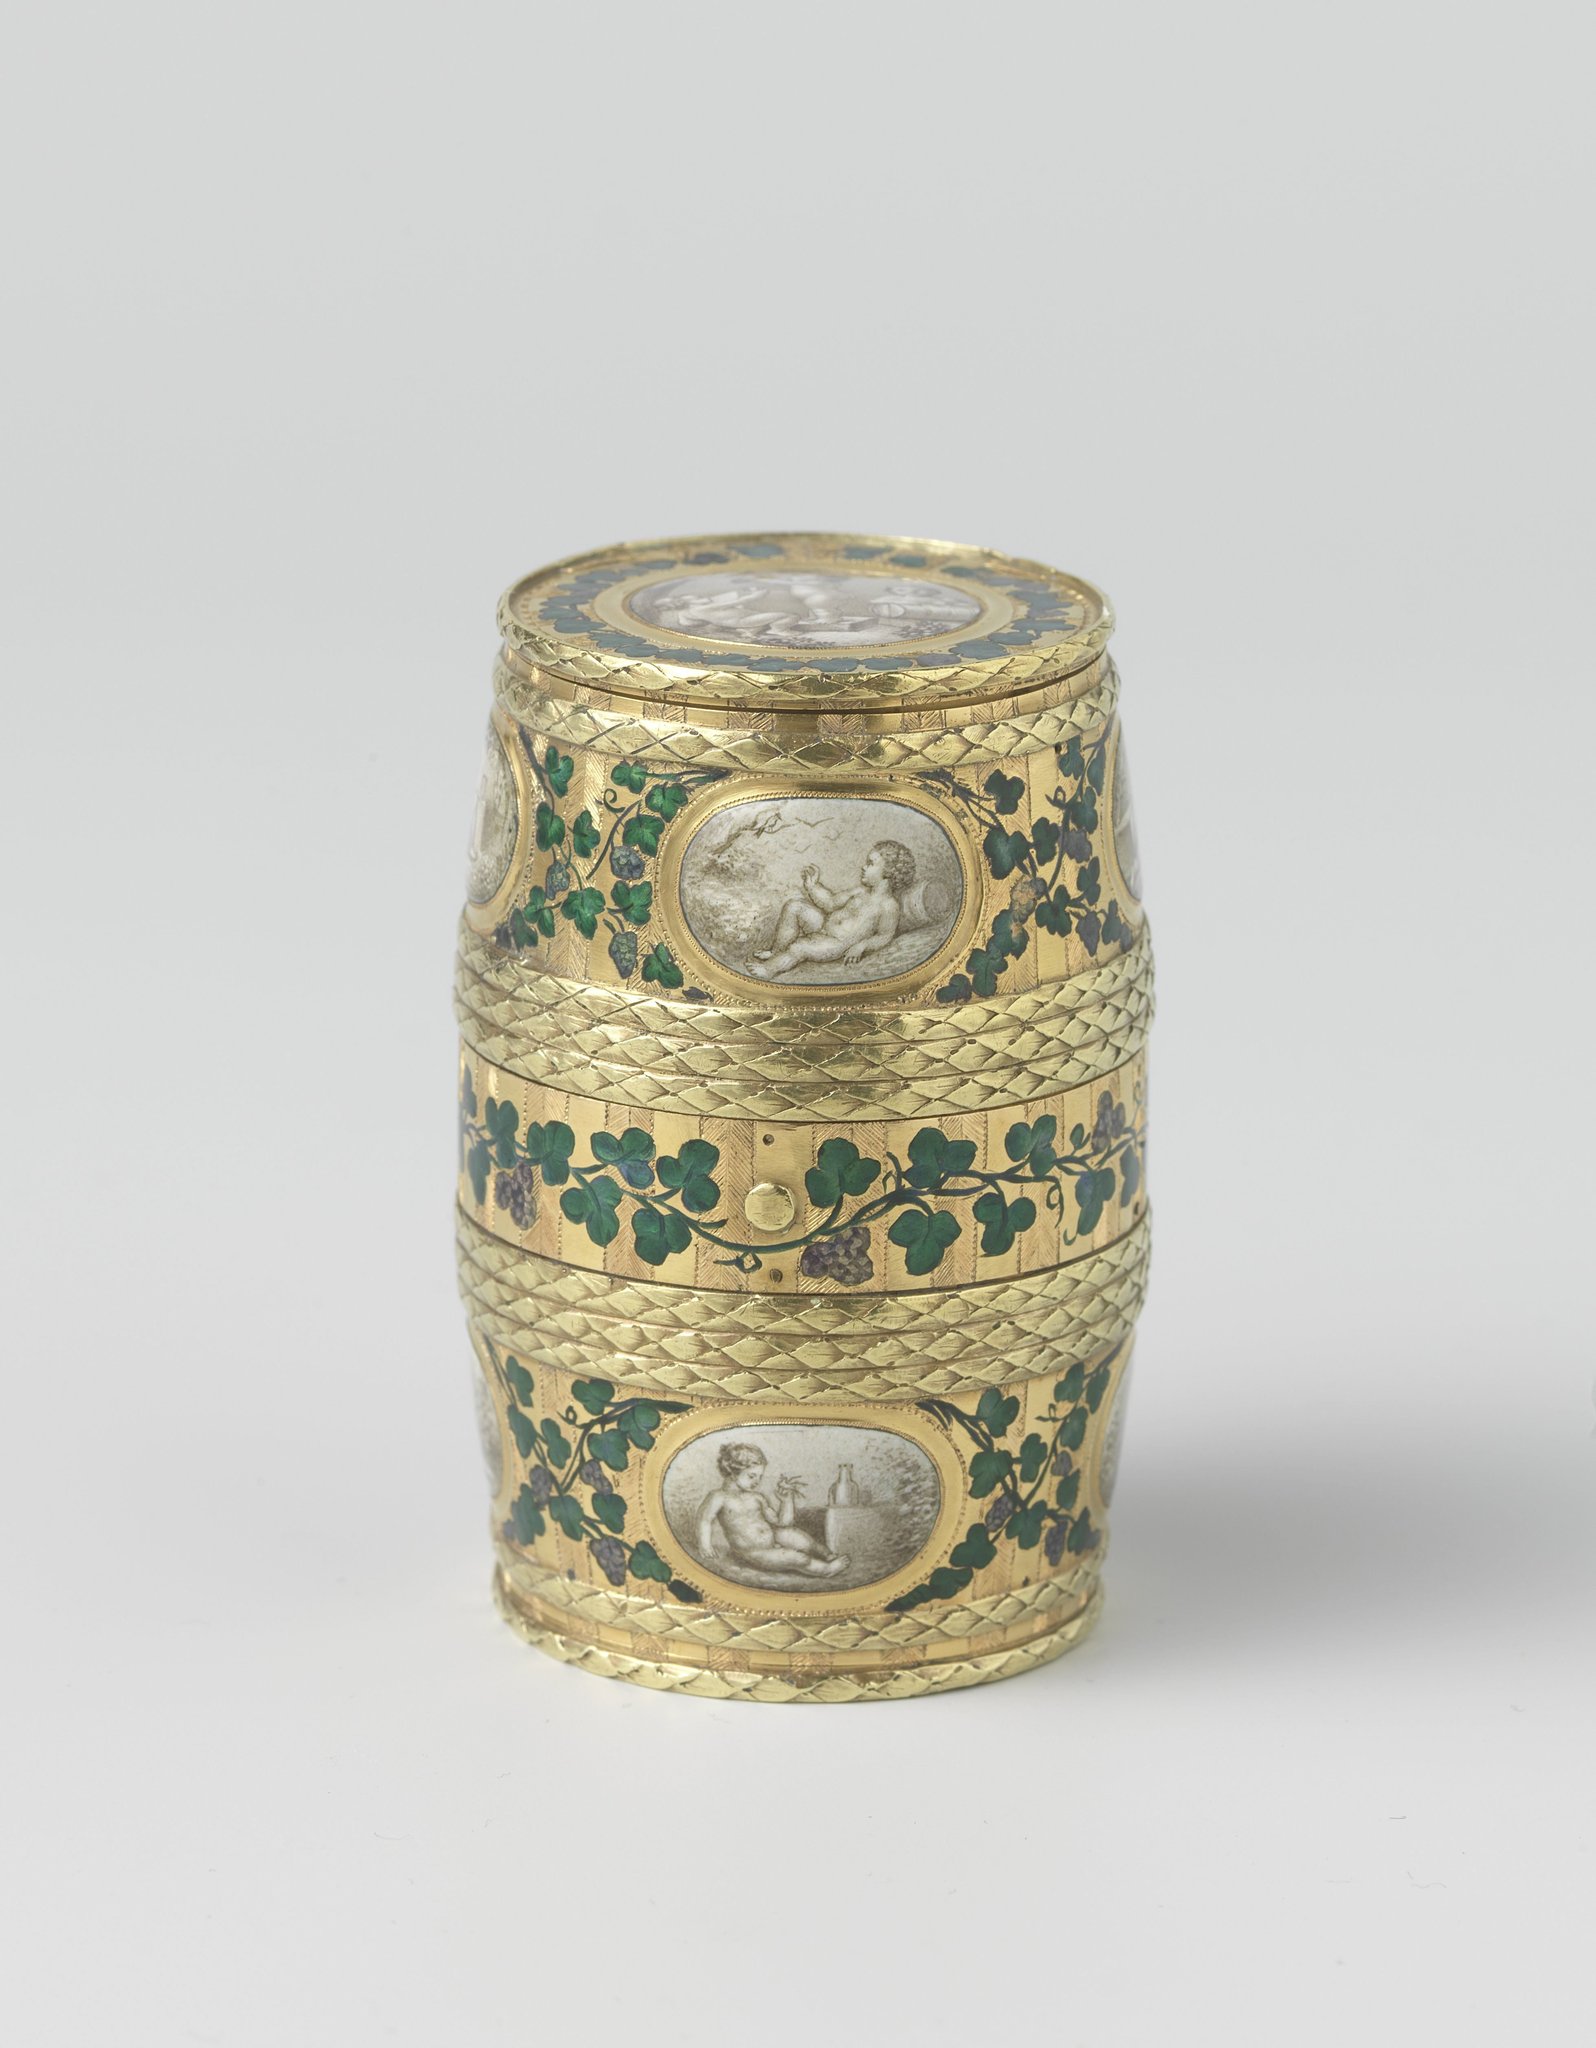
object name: snuffbox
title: Snuffbox in the shape of a wine caste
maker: jean-joseph barrière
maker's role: goldsmith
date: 1768-1769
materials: gold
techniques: enameling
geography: paris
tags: vine, cupids: 'amores', 'amoretti', 'putti'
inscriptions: maker's mark, alloy mark, date letter, duty mark, countermark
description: Gouden doos in de vorm van een ton. Tien ronde en ovale in grisaille geëmailleerde velden met amoretten. Daartussen groene wijnranken.